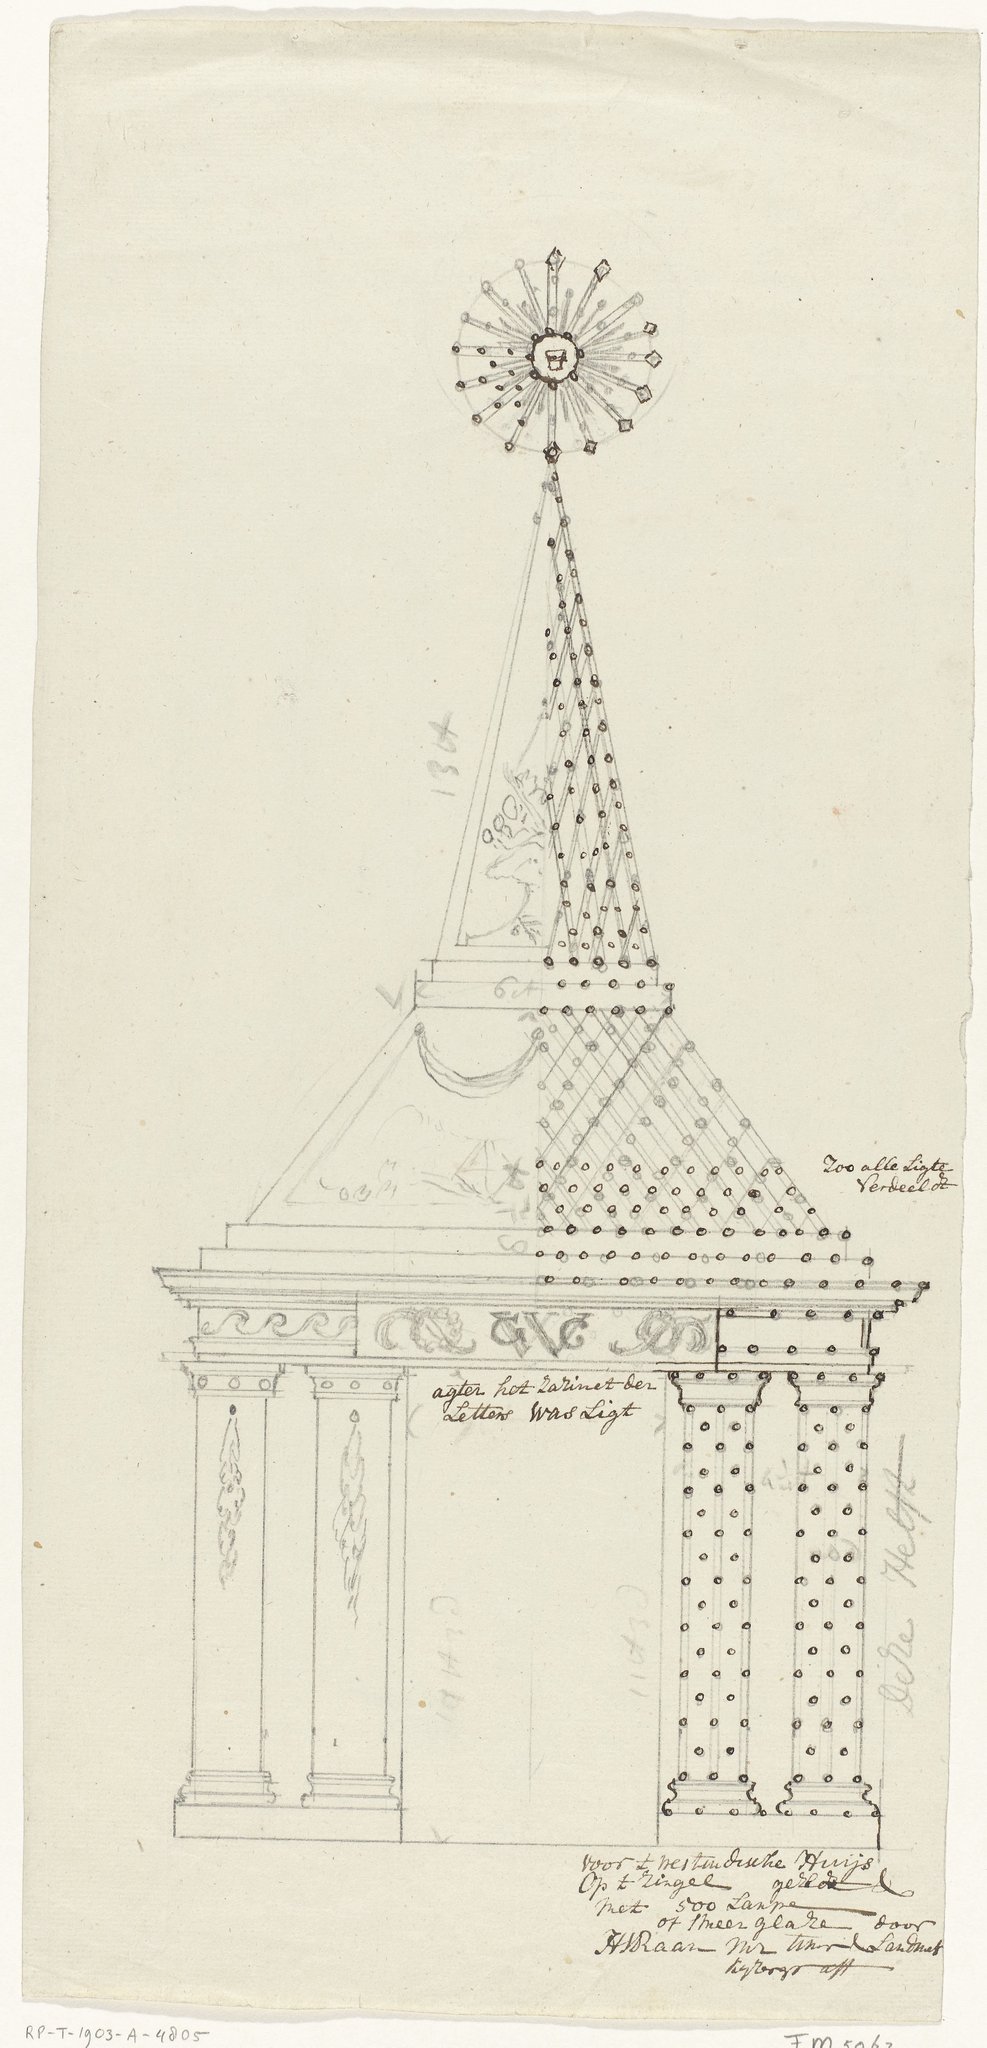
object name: design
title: Ontwerp voor illuminatie van het West-Indisch Huis te Amsterdam, 1788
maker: hendrik g. van raan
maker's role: draughtsman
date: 1788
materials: ink, paper, pencil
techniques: writing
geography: amsterdam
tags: the hague, william v (prince of orange), bonfire, fire-works (+ illumination, fire-works ~ festive activities), amsterdam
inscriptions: inscription: ‘voor t westindische Huijs Op 't Singel ... met 500 Lampen of smeer glazen door HvRaan Mr ... Landmeter kysersgraft’, collector's mark: Lugt 2228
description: Ontwerp voor de illuminatie van het West-Indisch Huis aan het Singel te Amsterdam. Met notities over constructie en inrichting. Onderdeel van een groep van ontwerptekeningen van de architect Hendrik G. van Raan voor illuminaties en decoraties te Amsterdam op de 40ste verjaardag van prins Willem V op 8 maart 1788.